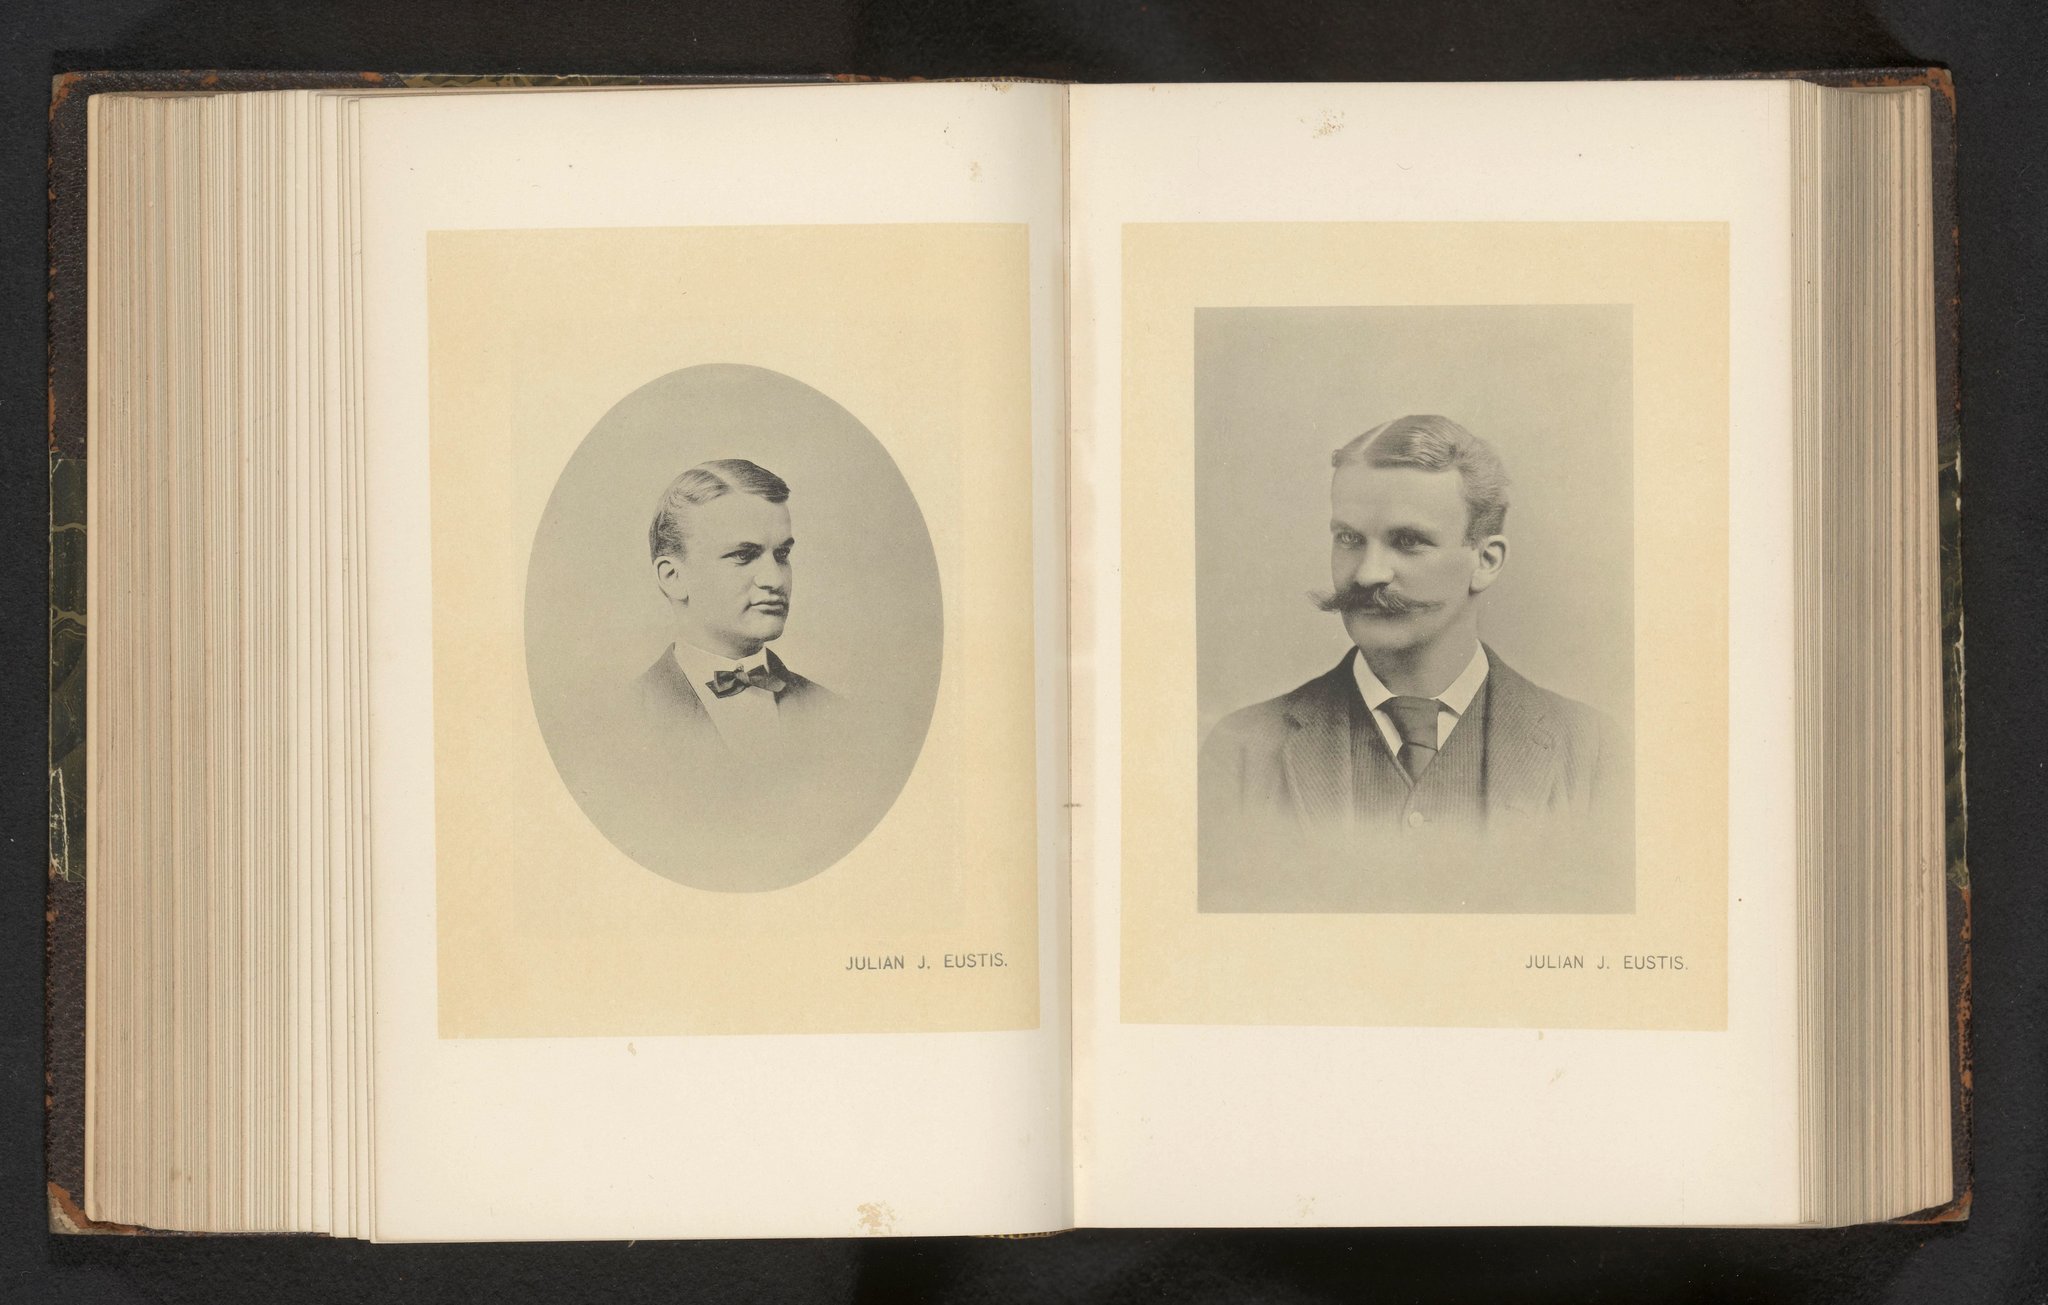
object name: photomechanical print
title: Julian J. Eustis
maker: Anonymous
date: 1869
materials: paper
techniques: photoaquatint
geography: boston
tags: adult man